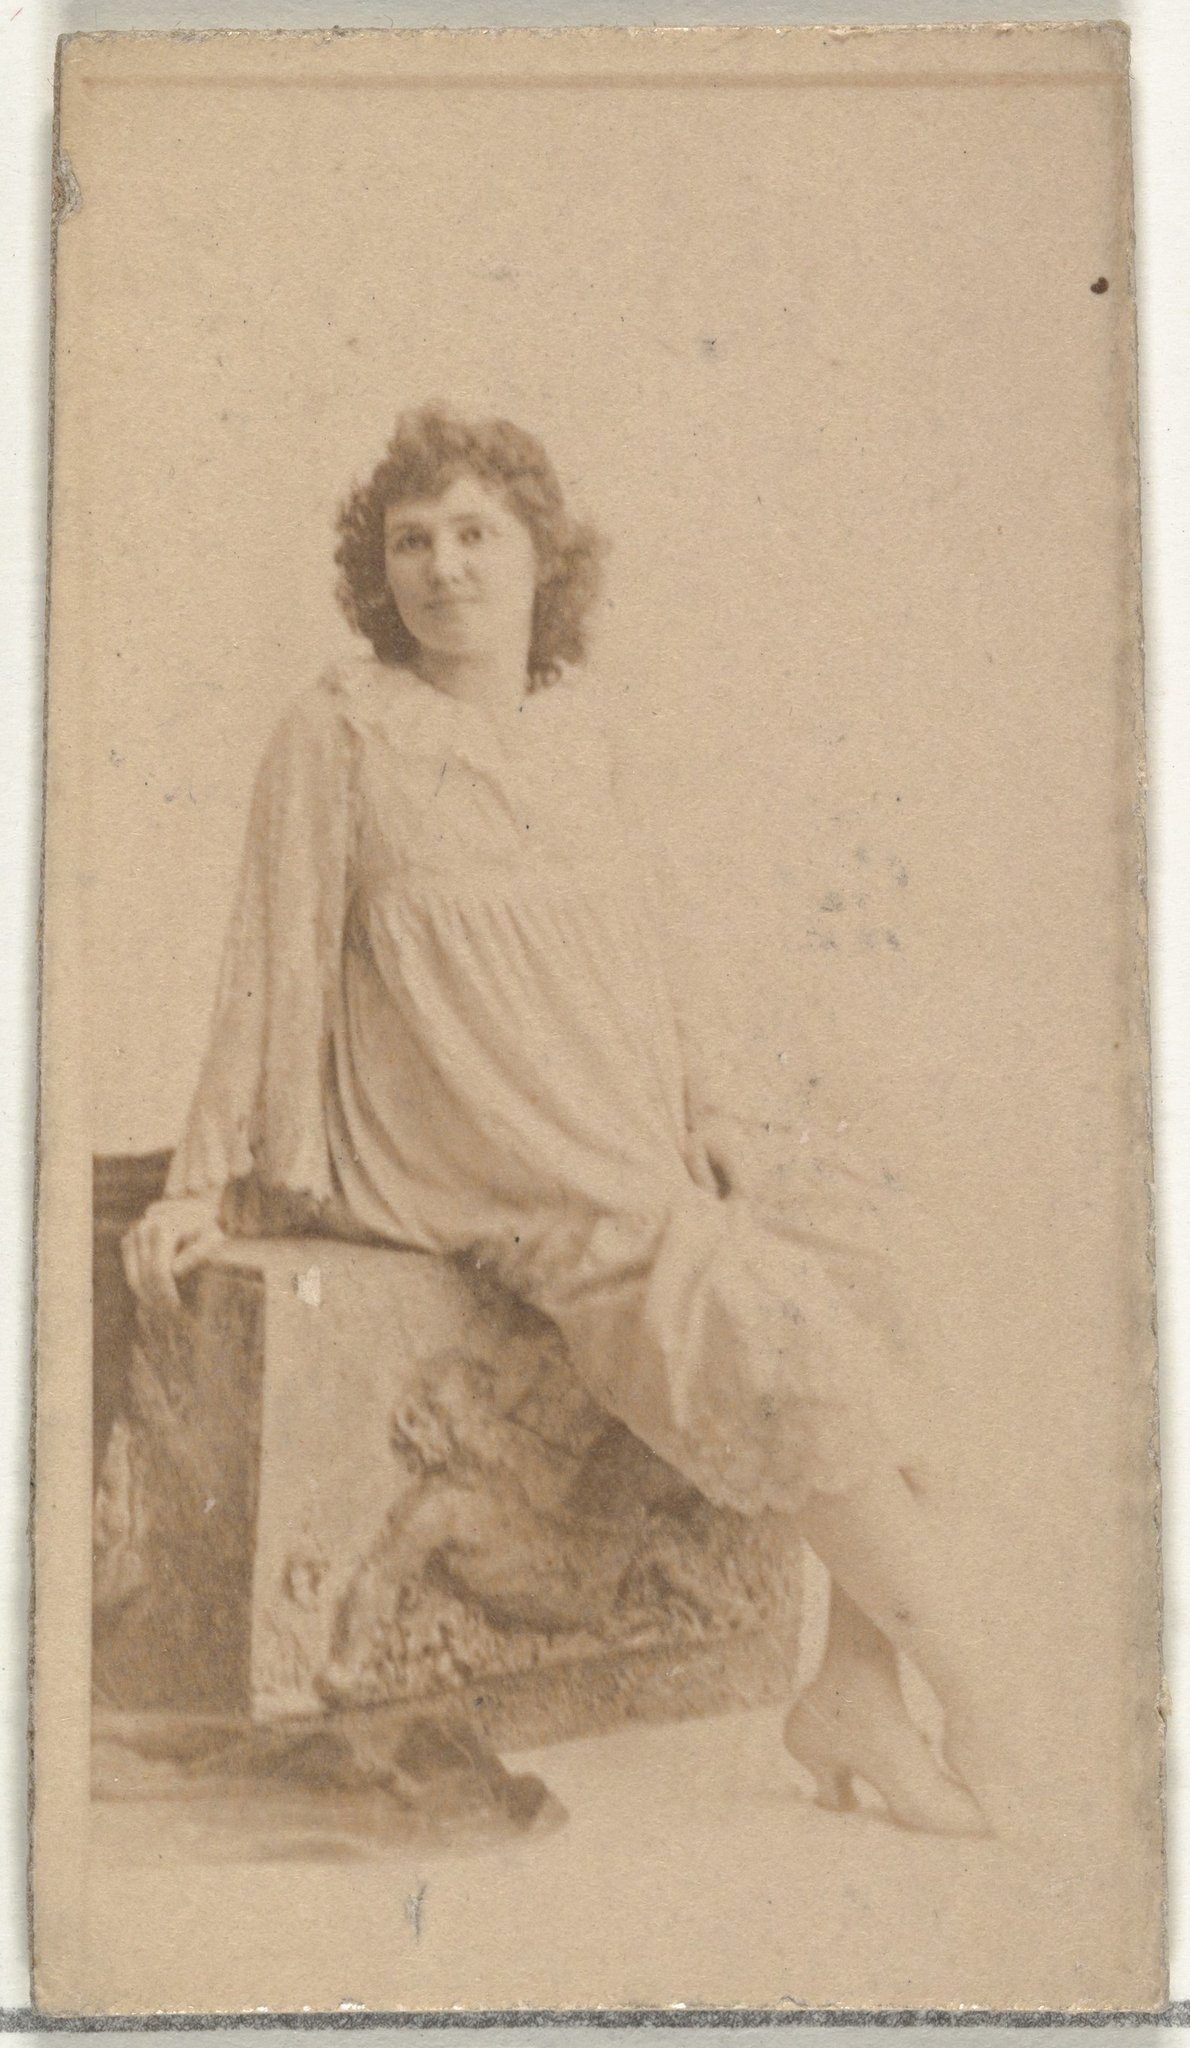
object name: photograph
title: [Seated actress dressed in loose white gown], from the Actors and Actresses series (N145-8) issued by Duke Sons & Co. to promote Duke Cigarettes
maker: w. duke, sons & co.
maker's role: publisher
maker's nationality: american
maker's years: 1870-1920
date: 1891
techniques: albumen silver print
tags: portraits,women,actresses